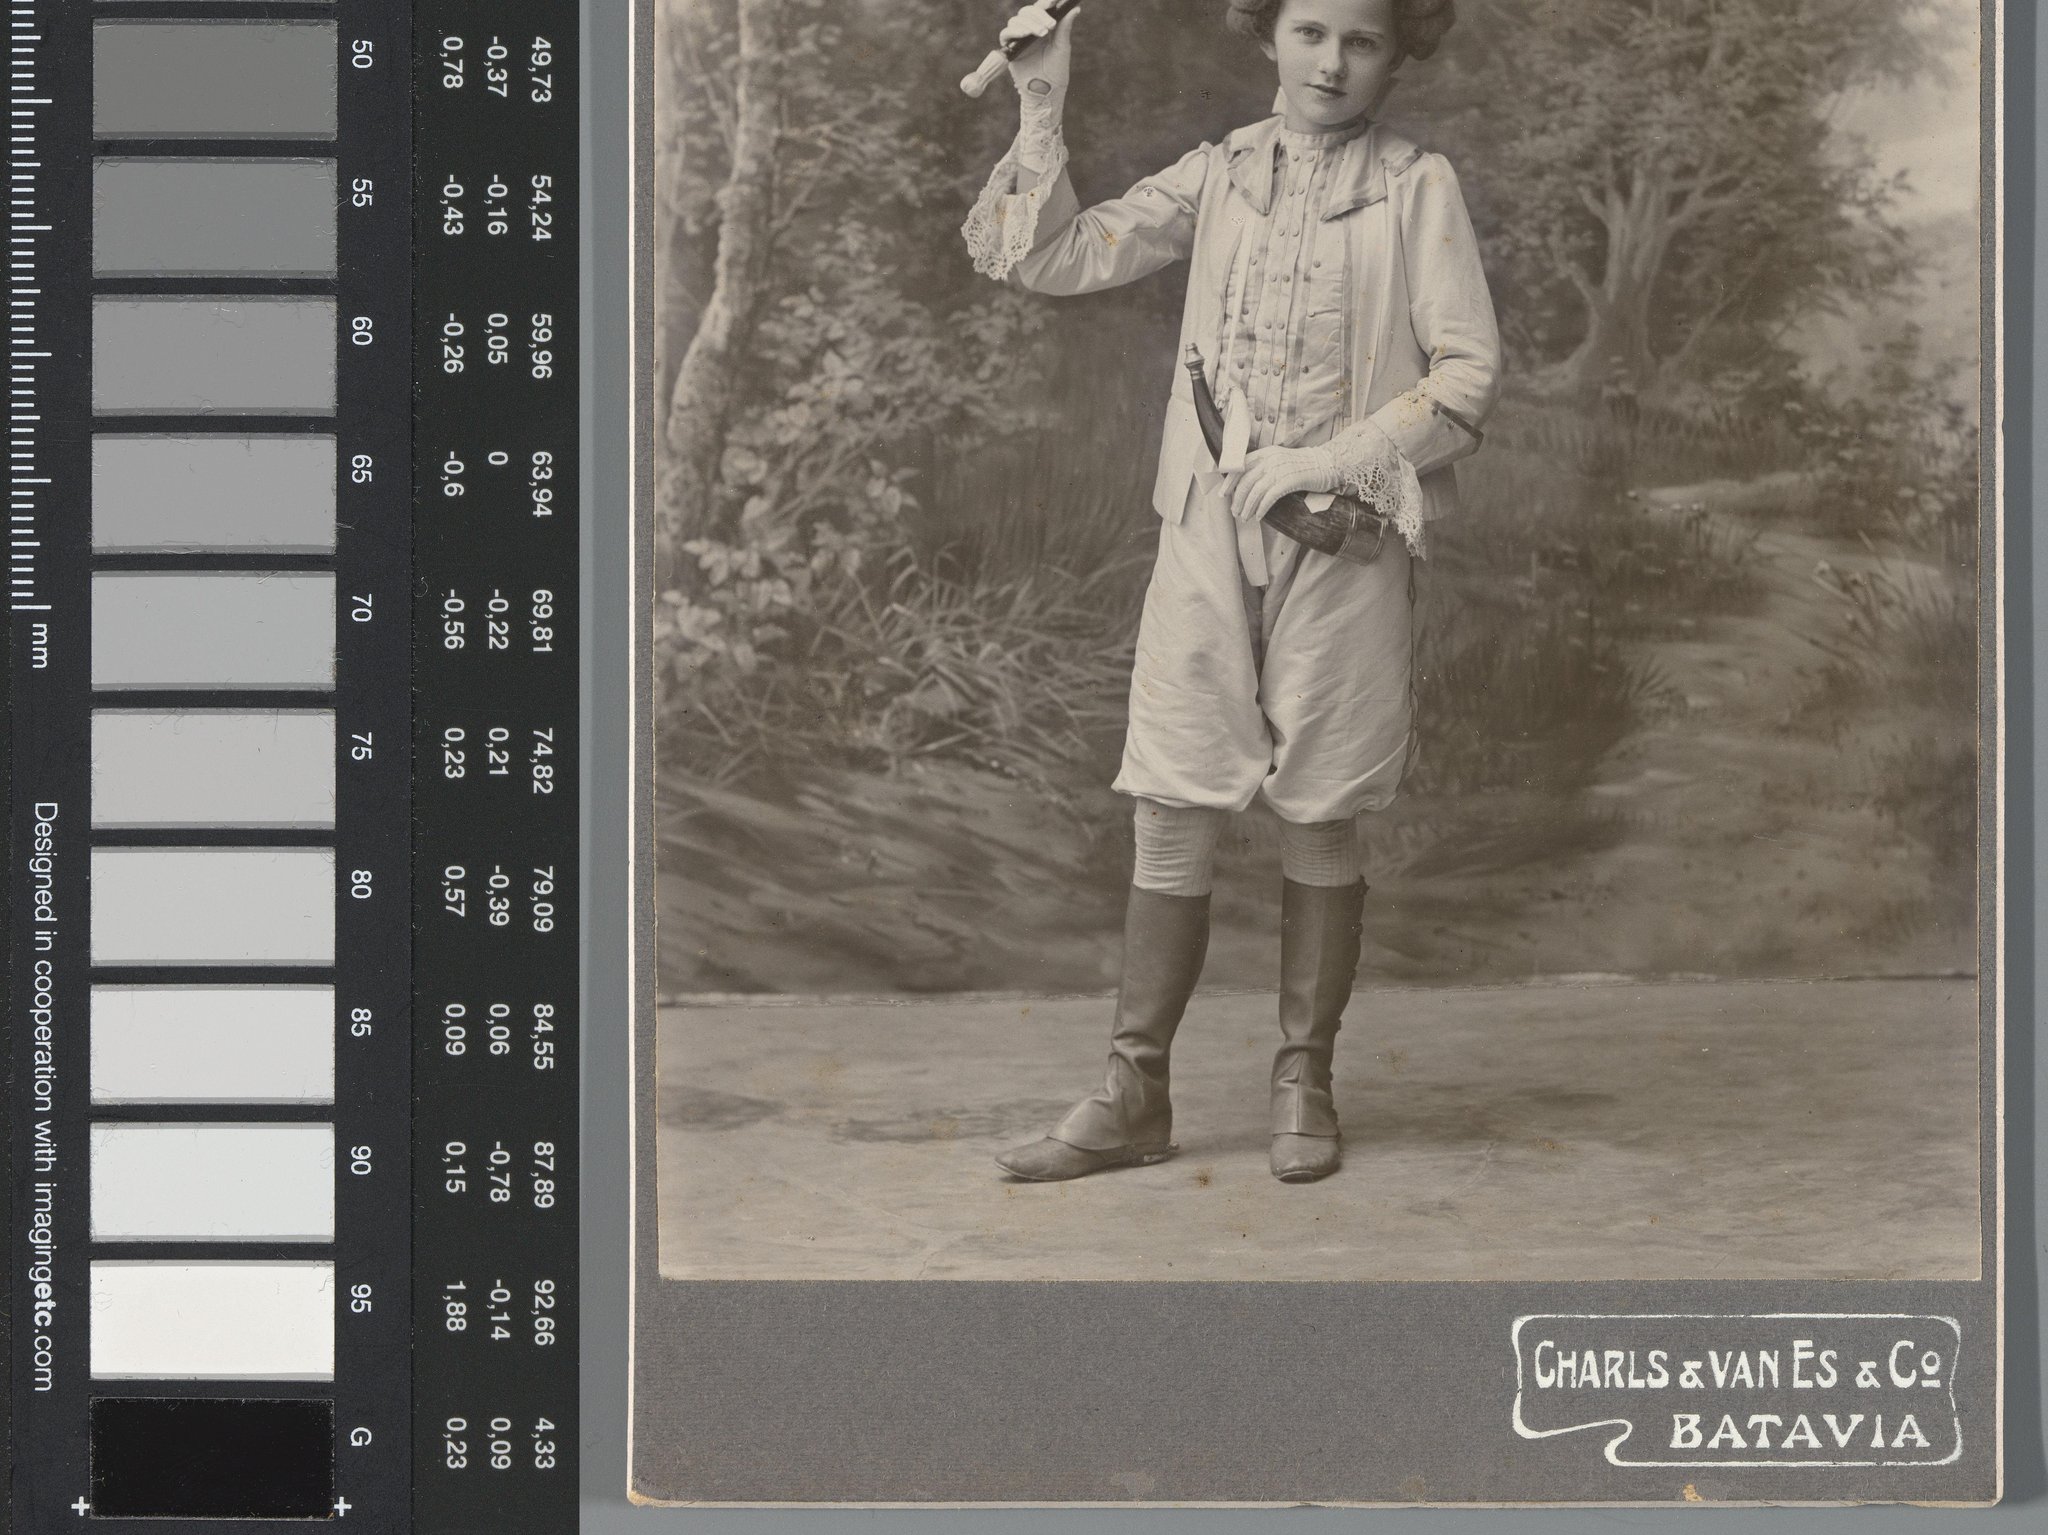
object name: cabinet photograph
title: Studioportret van Loentje Furnee geboren Onnen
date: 1900-1910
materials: cardboard, photographic support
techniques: albumen print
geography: batavia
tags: amsterdam, carolina frederika onnen (lien/loen)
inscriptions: name: ‘CHARLS & VAN ES & Co / BATAVIA’, name: ‘Loentje Furnee / geb. Onnen’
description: Staand meisje met pruik, jachthoorn en zweep tegen een achtergrond met bosschages.